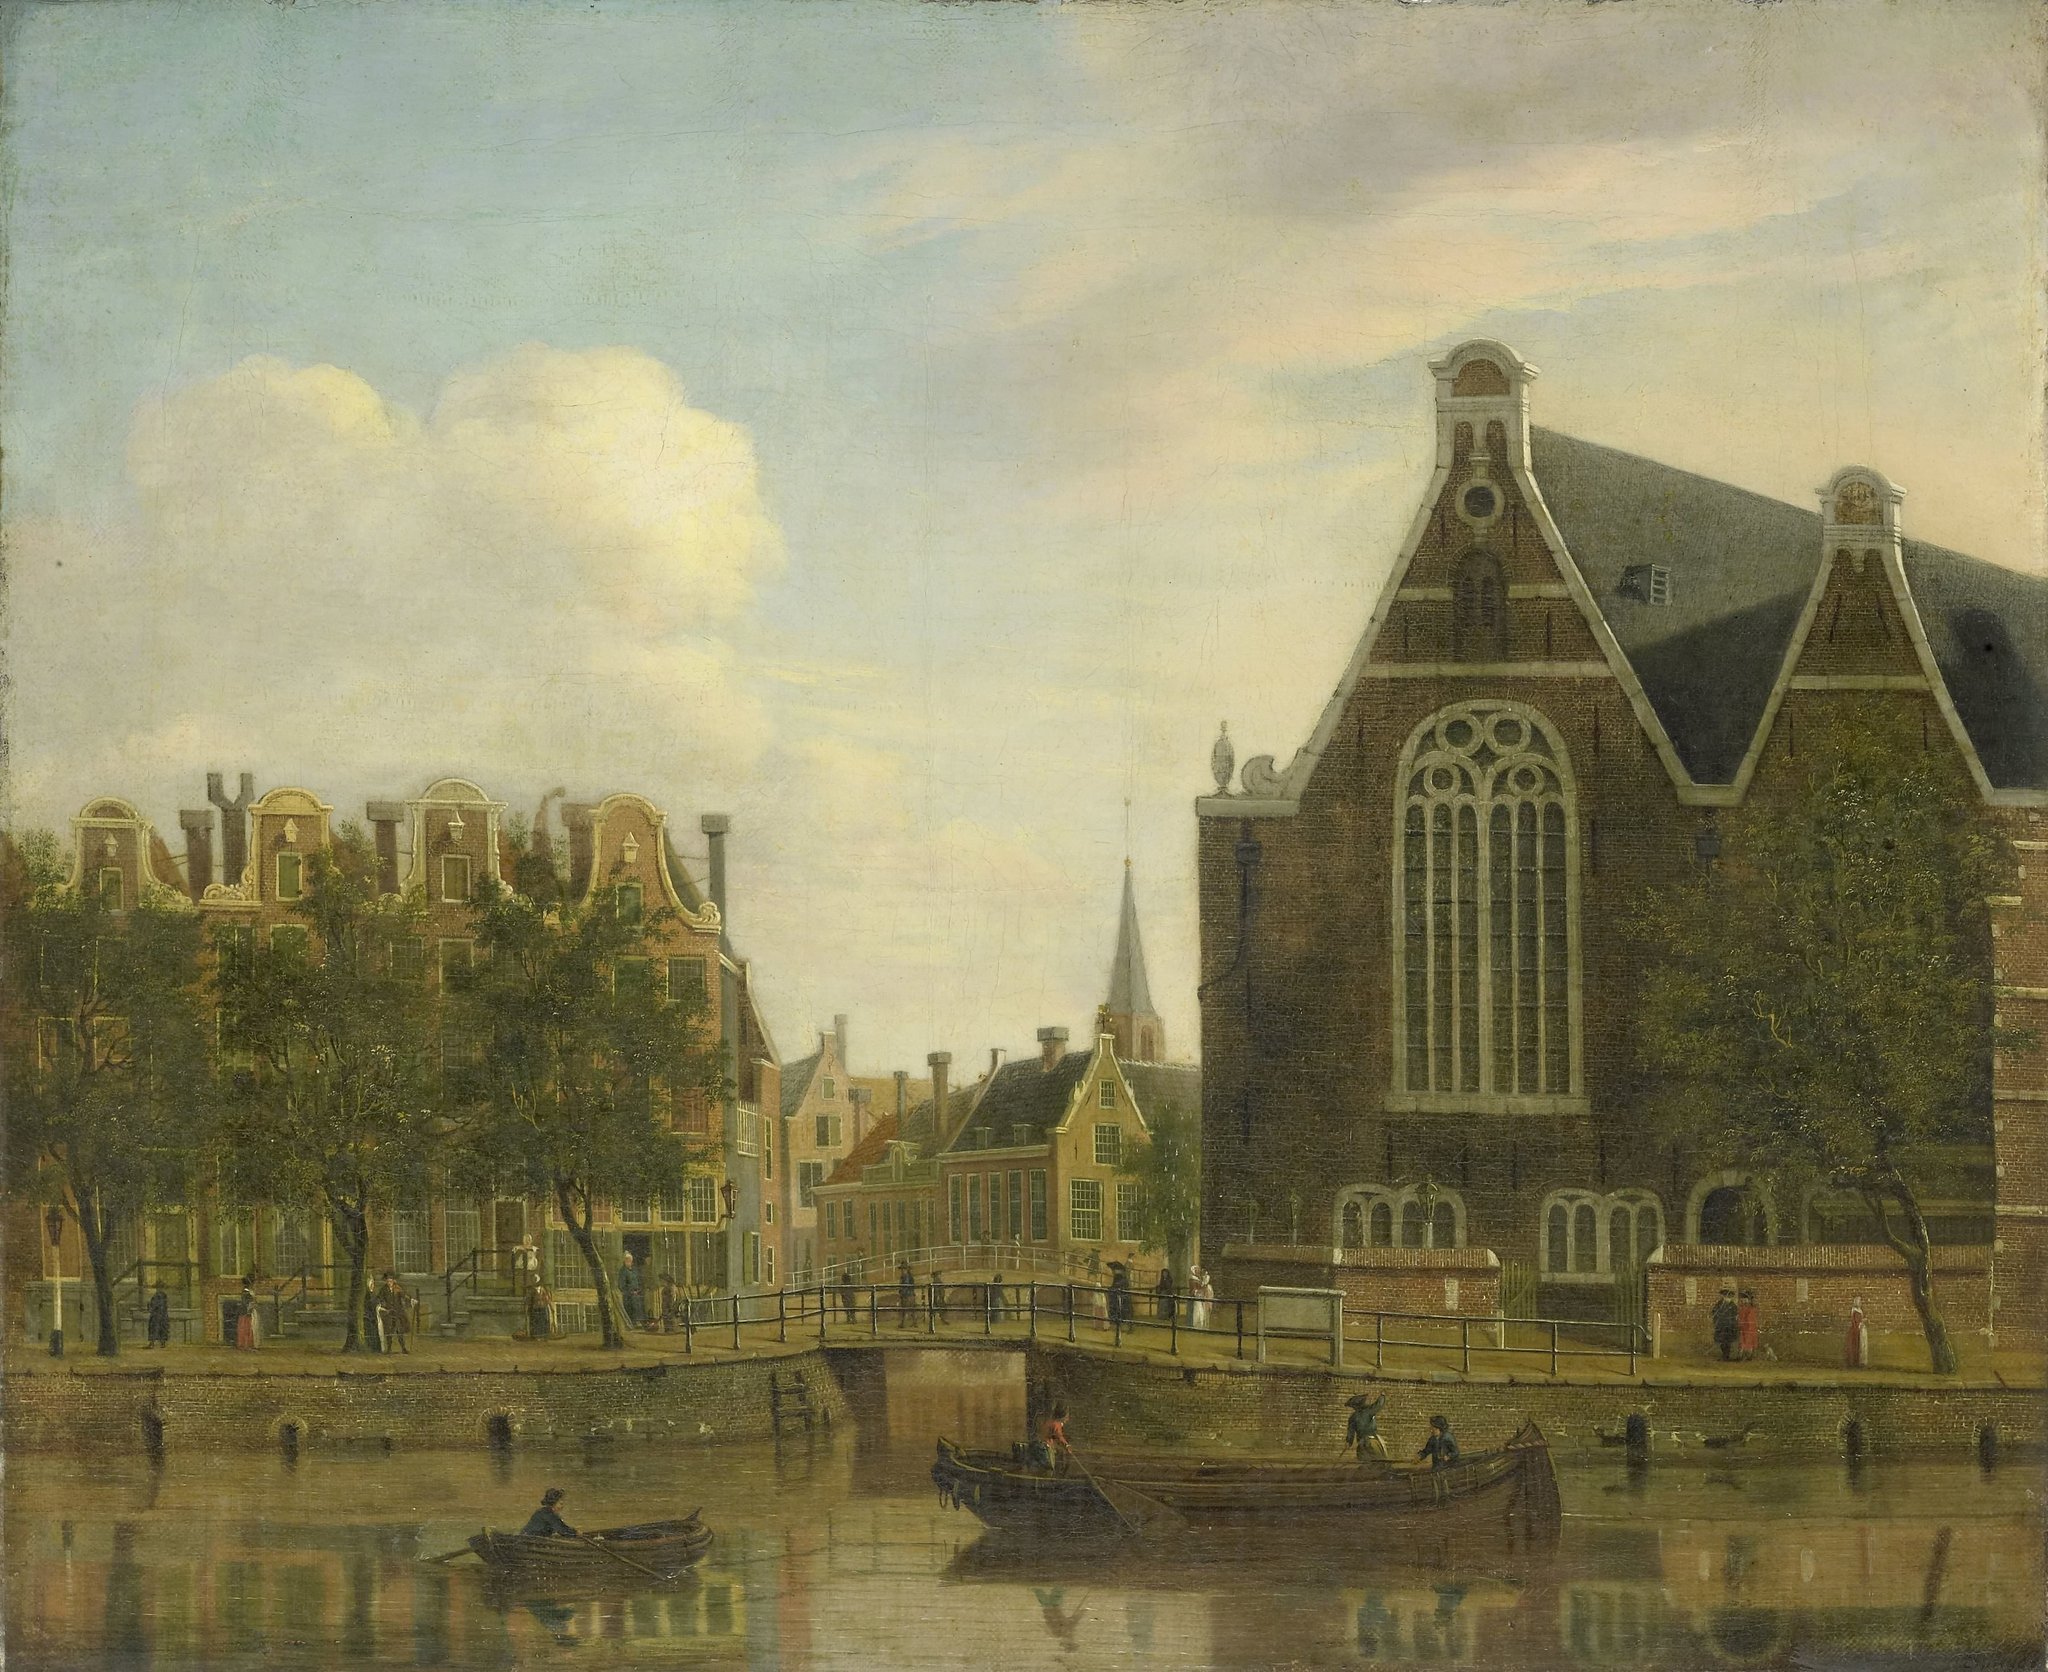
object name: painting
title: The so-called Boerenverdriet on the Spui, Amsterdam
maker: jan ekels (i)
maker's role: draughtsman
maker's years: 1724-1781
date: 1750-1781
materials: canvas, oil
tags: bridge in city across river, canal, etc. (+ city(-scape) with figures, staffage), canals, waters (in city) (+ city(-scape) with figures, staffage)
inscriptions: signature (false): ‘J.B. Heyde’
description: Het zogenaamde Boerenverdriet aan het Spui te Amsterdam. Gezicht vanaf het Singel met rechts de Lutherse kerk, over de oude brug een doorkijk naar de toren van het Bagijnhof. Op het water van de gracht varen enkele boten.